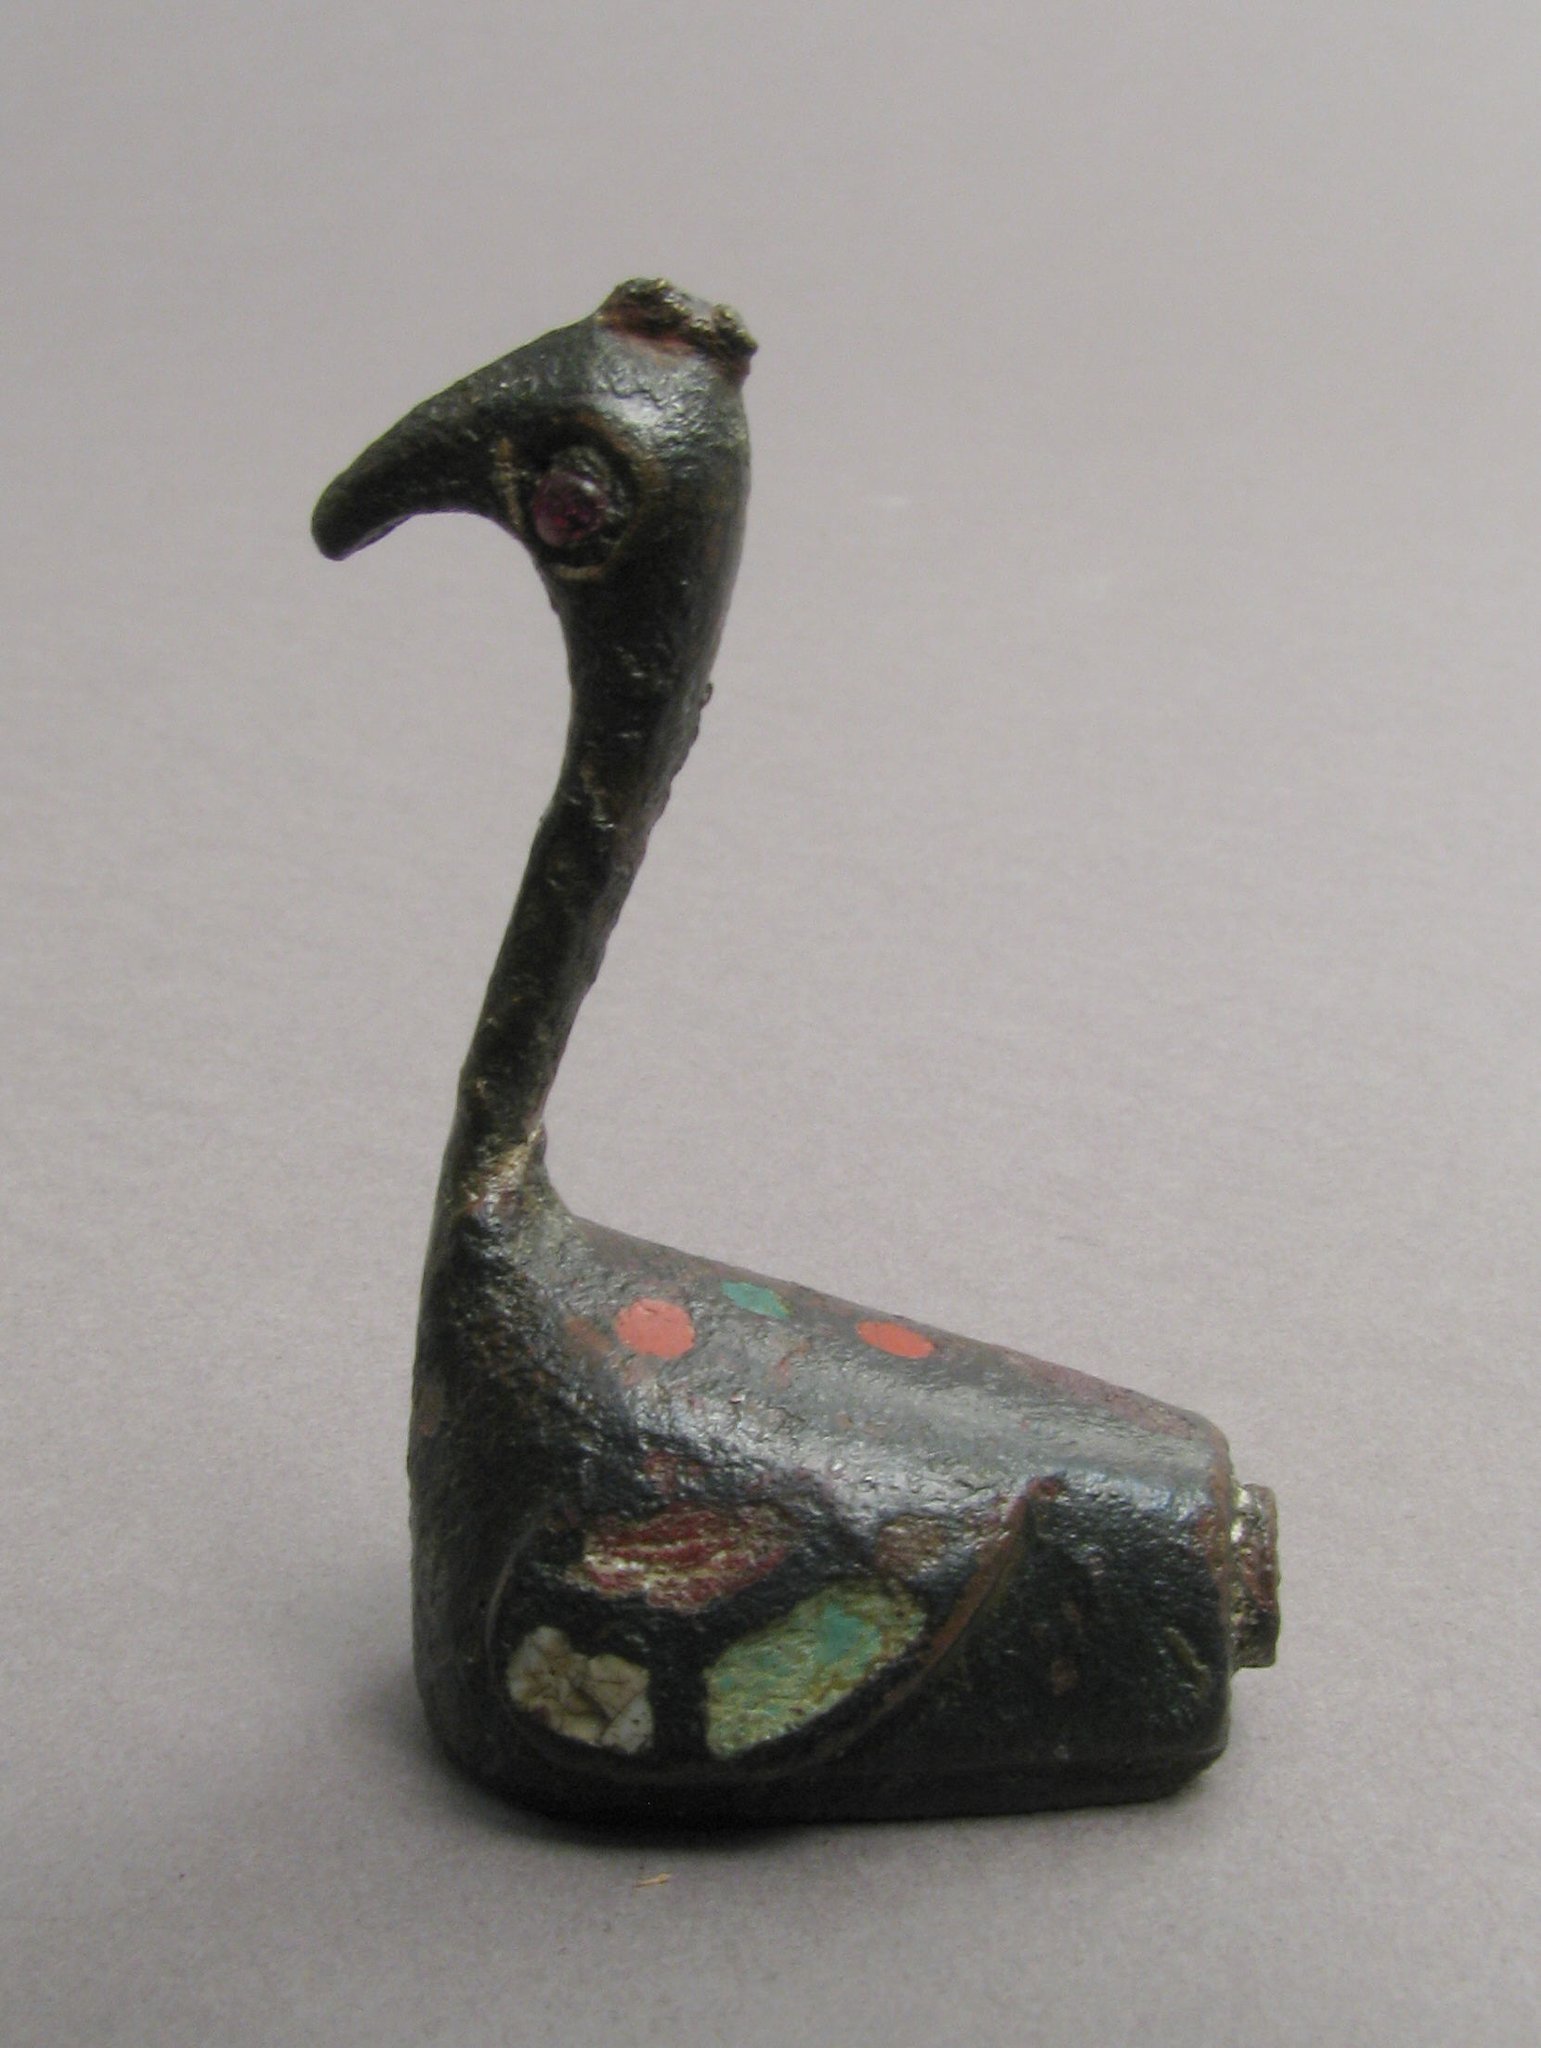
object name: brooch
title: Brooch in the Form of a Peacock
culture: roman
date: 101-300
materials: bronze, enamel, gemstone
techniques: enamel